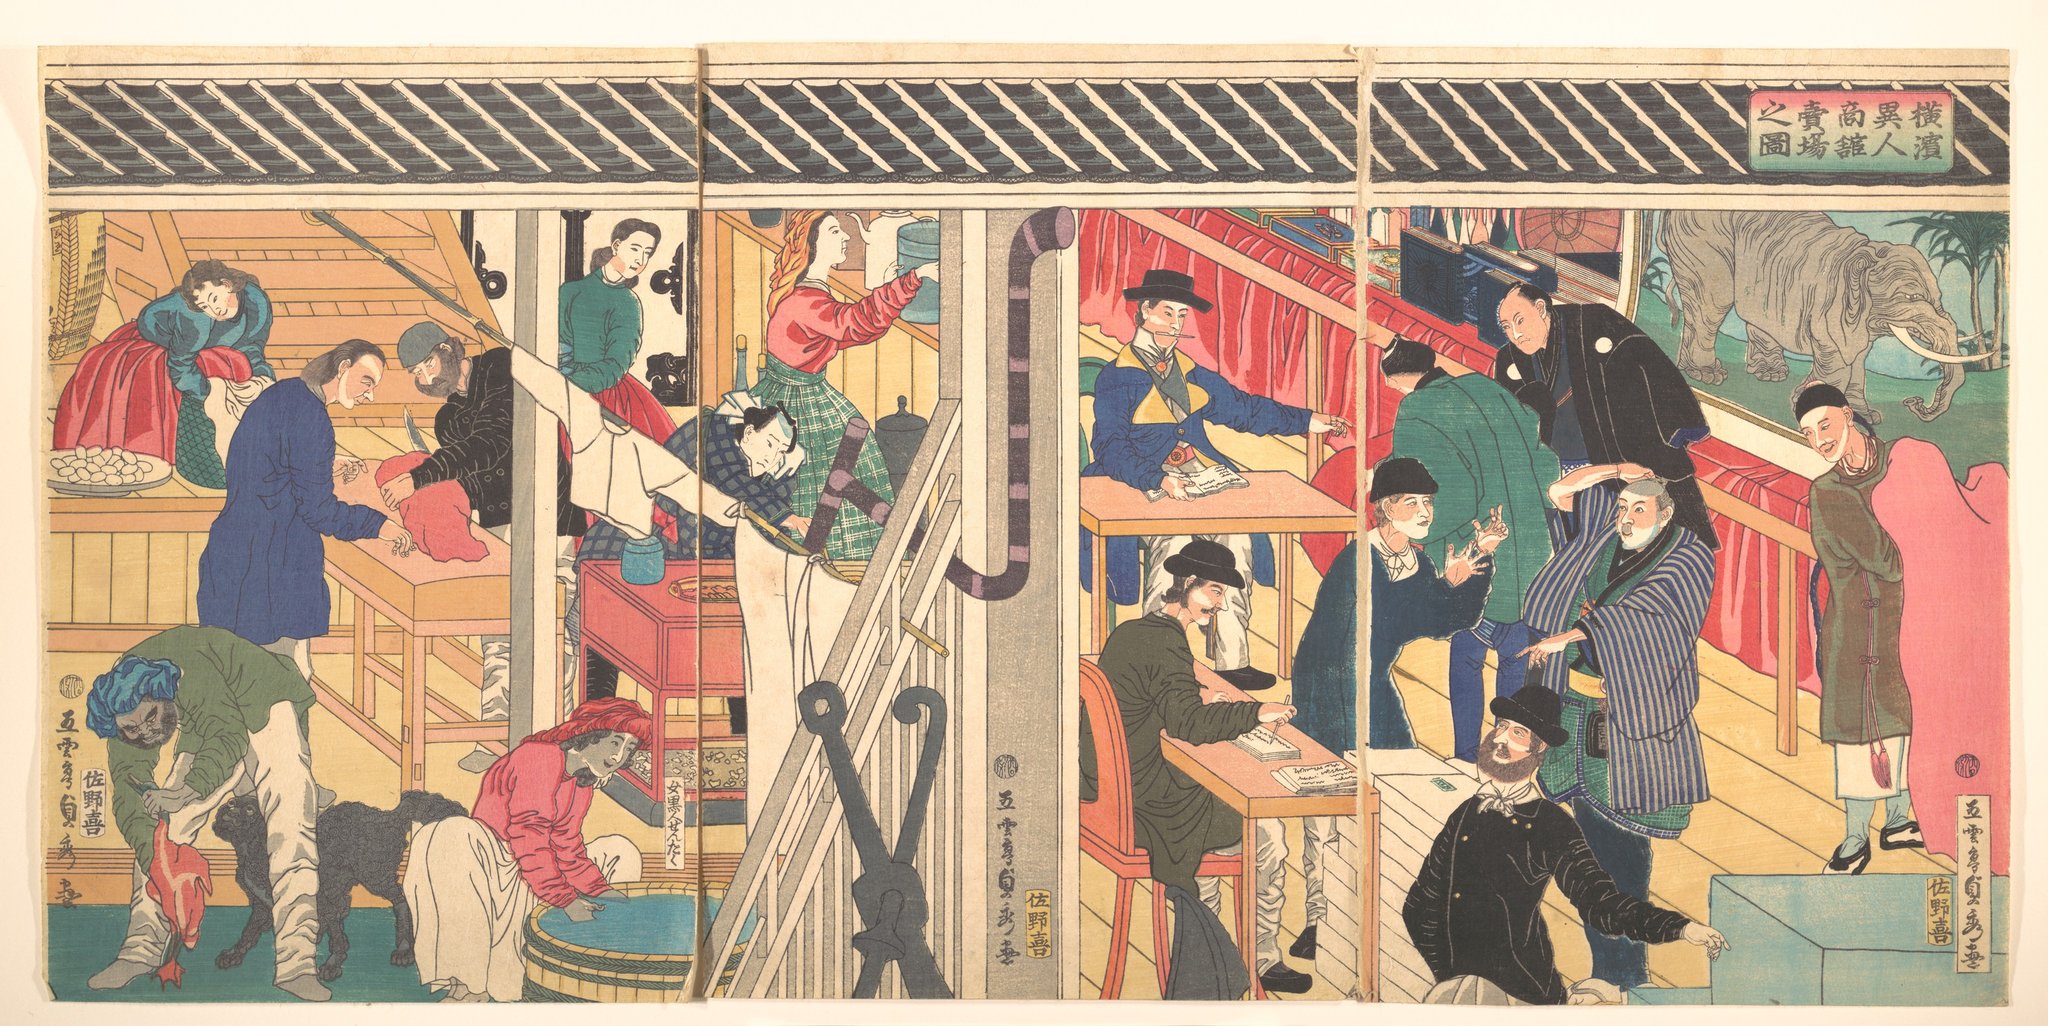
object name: print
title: Foreign Business Establishment in Yokohama (Yokohama ijin shōkan uriba no zu)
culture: japanese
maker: utagawa (gountei) sadahide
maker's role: artist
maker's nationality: japanese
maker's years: 1807-1873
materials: ink, paper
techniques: nishiki e, woodblock print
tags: elephants,crowd,markets,merchants